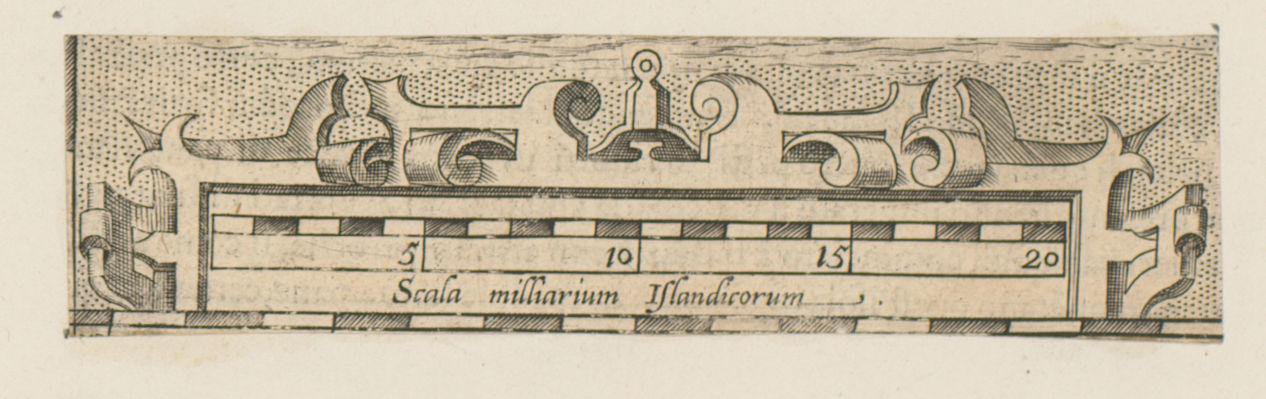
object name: album leaf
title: Theatrum Orbis Terrarum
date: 1590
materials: paper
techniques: engraving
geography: antwerp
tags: scrollwork, strapwork ~ ornament, ornament ~ cartouche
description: Langwerpige cartouche met rolwerk en schaalstok (Scala milliarium Islandicorum). De cartouche is een fragment van een kaart van IJsland. De prent maakt deel uit van een album.